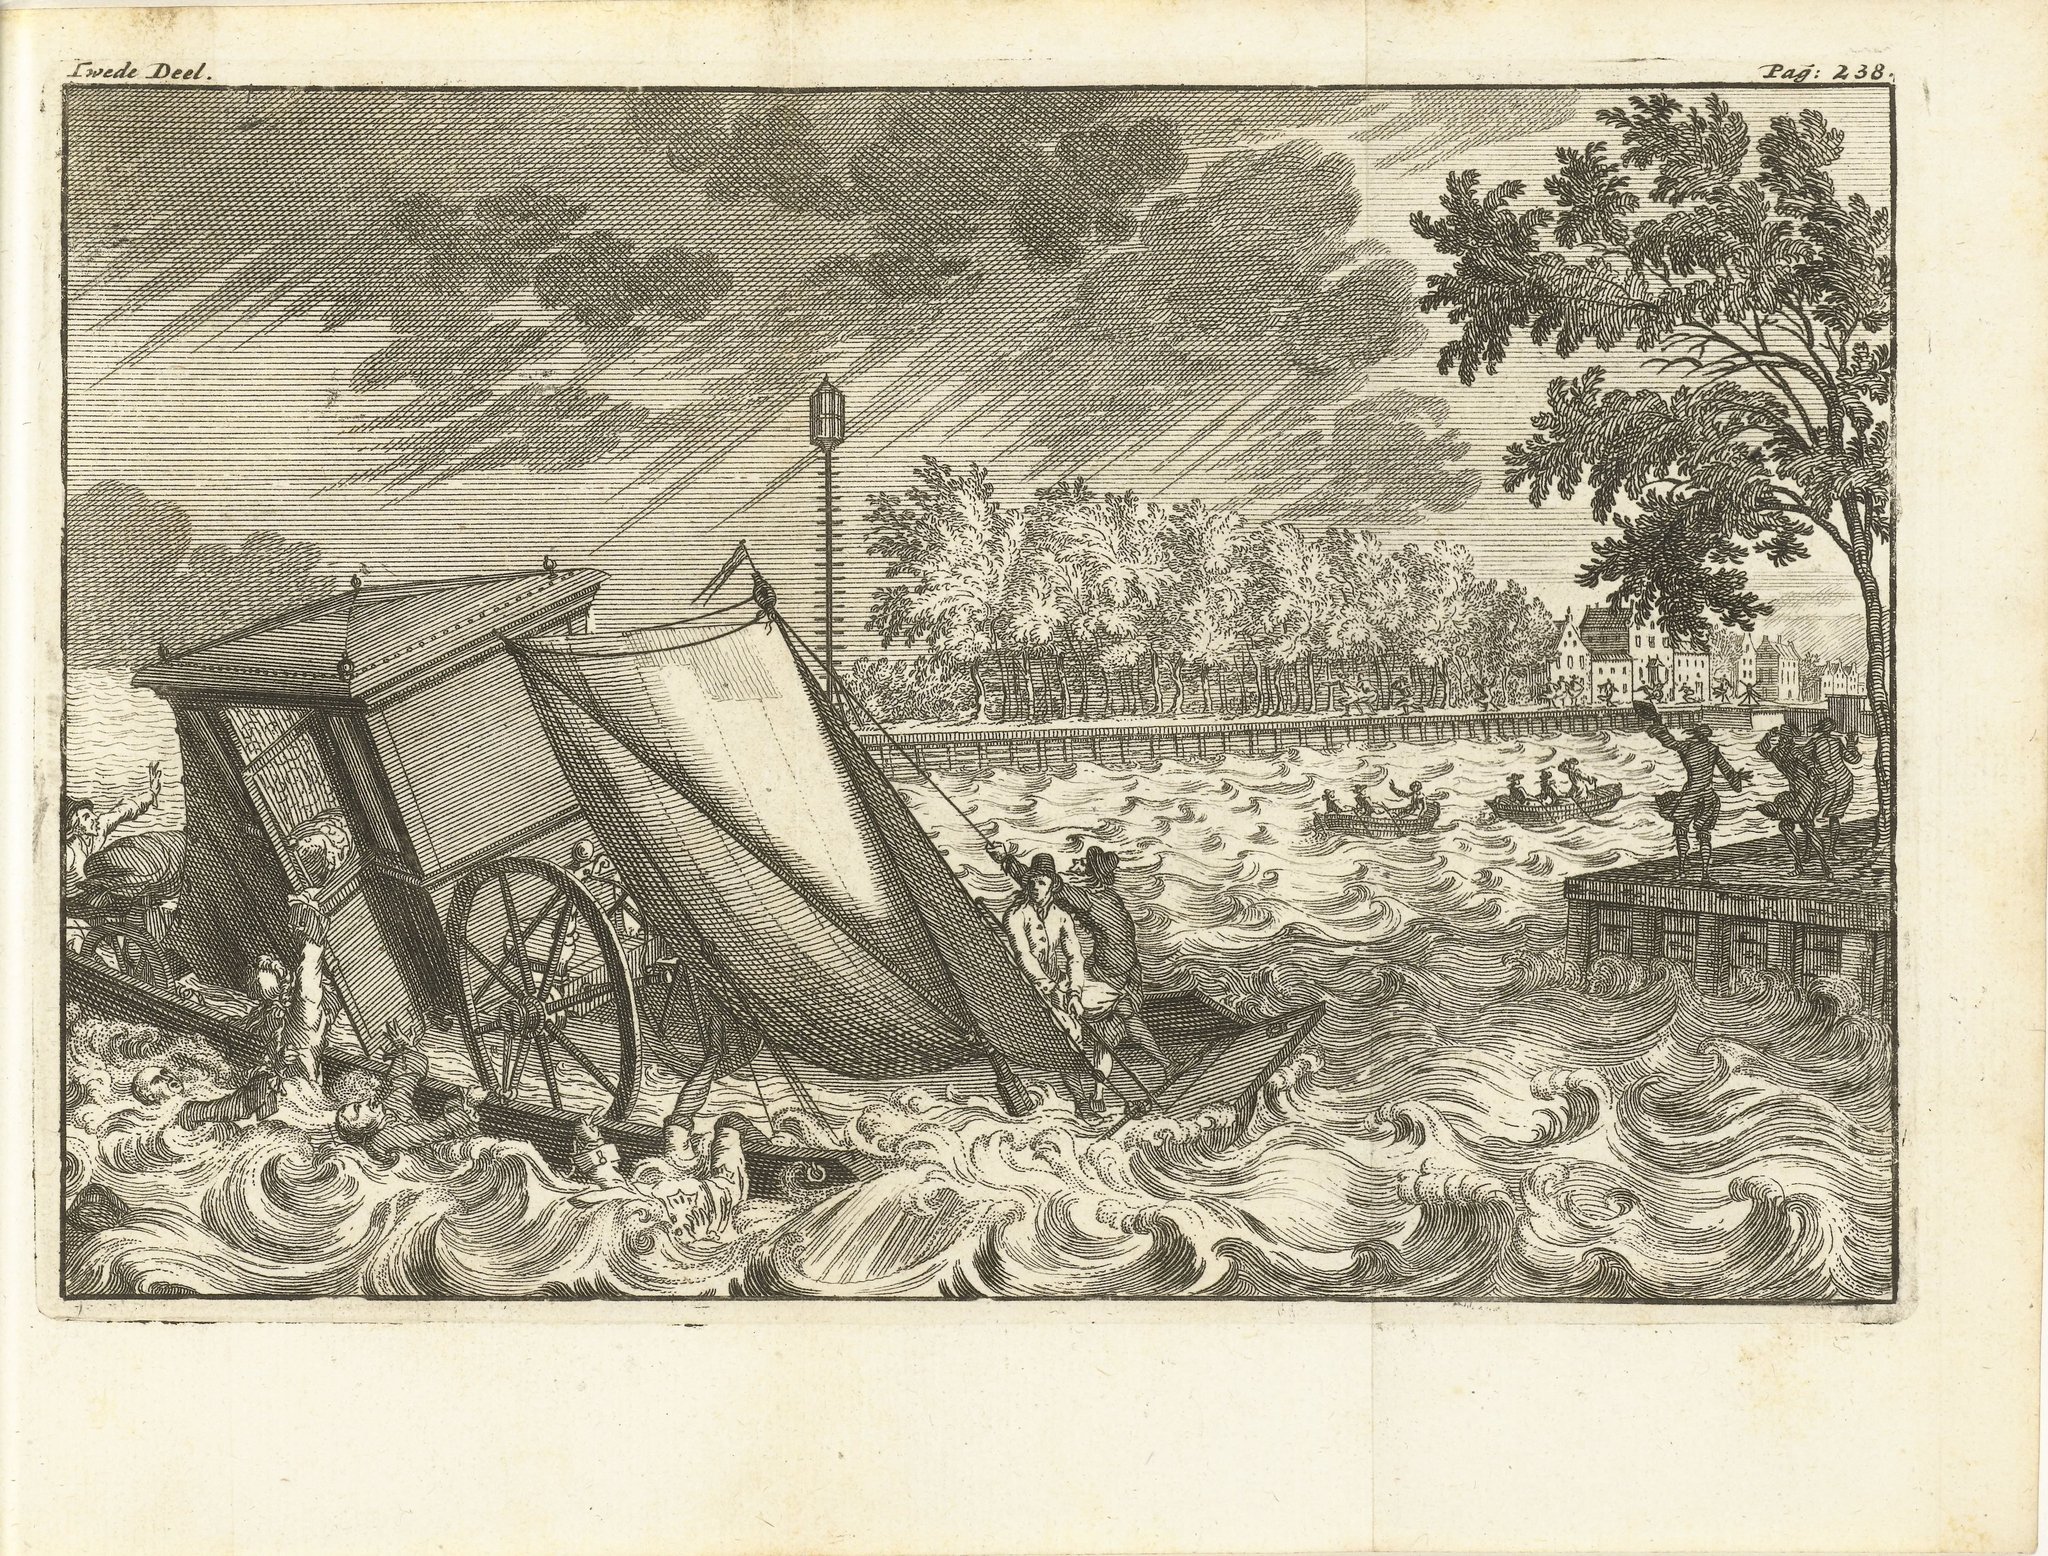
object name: print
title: Verdrinken van Johan Willem Friso, 1711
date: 1714-1716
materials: paper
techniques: etching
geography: amsterdam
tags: johan willem friso (prins van oranje-nassau), death by drowning (non-violent)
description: Prins Johan Willem Friso verdrinkt op 14 juli 1711 bij het oversteken van het Hollands Diep bij Moerdijk. Illustratie in de Nederlandse vertaling uit 1716 van J. Lamigue, Het leven van Zyne Hoogheit Johan Willem Friso, dl. II, p. 238/239.